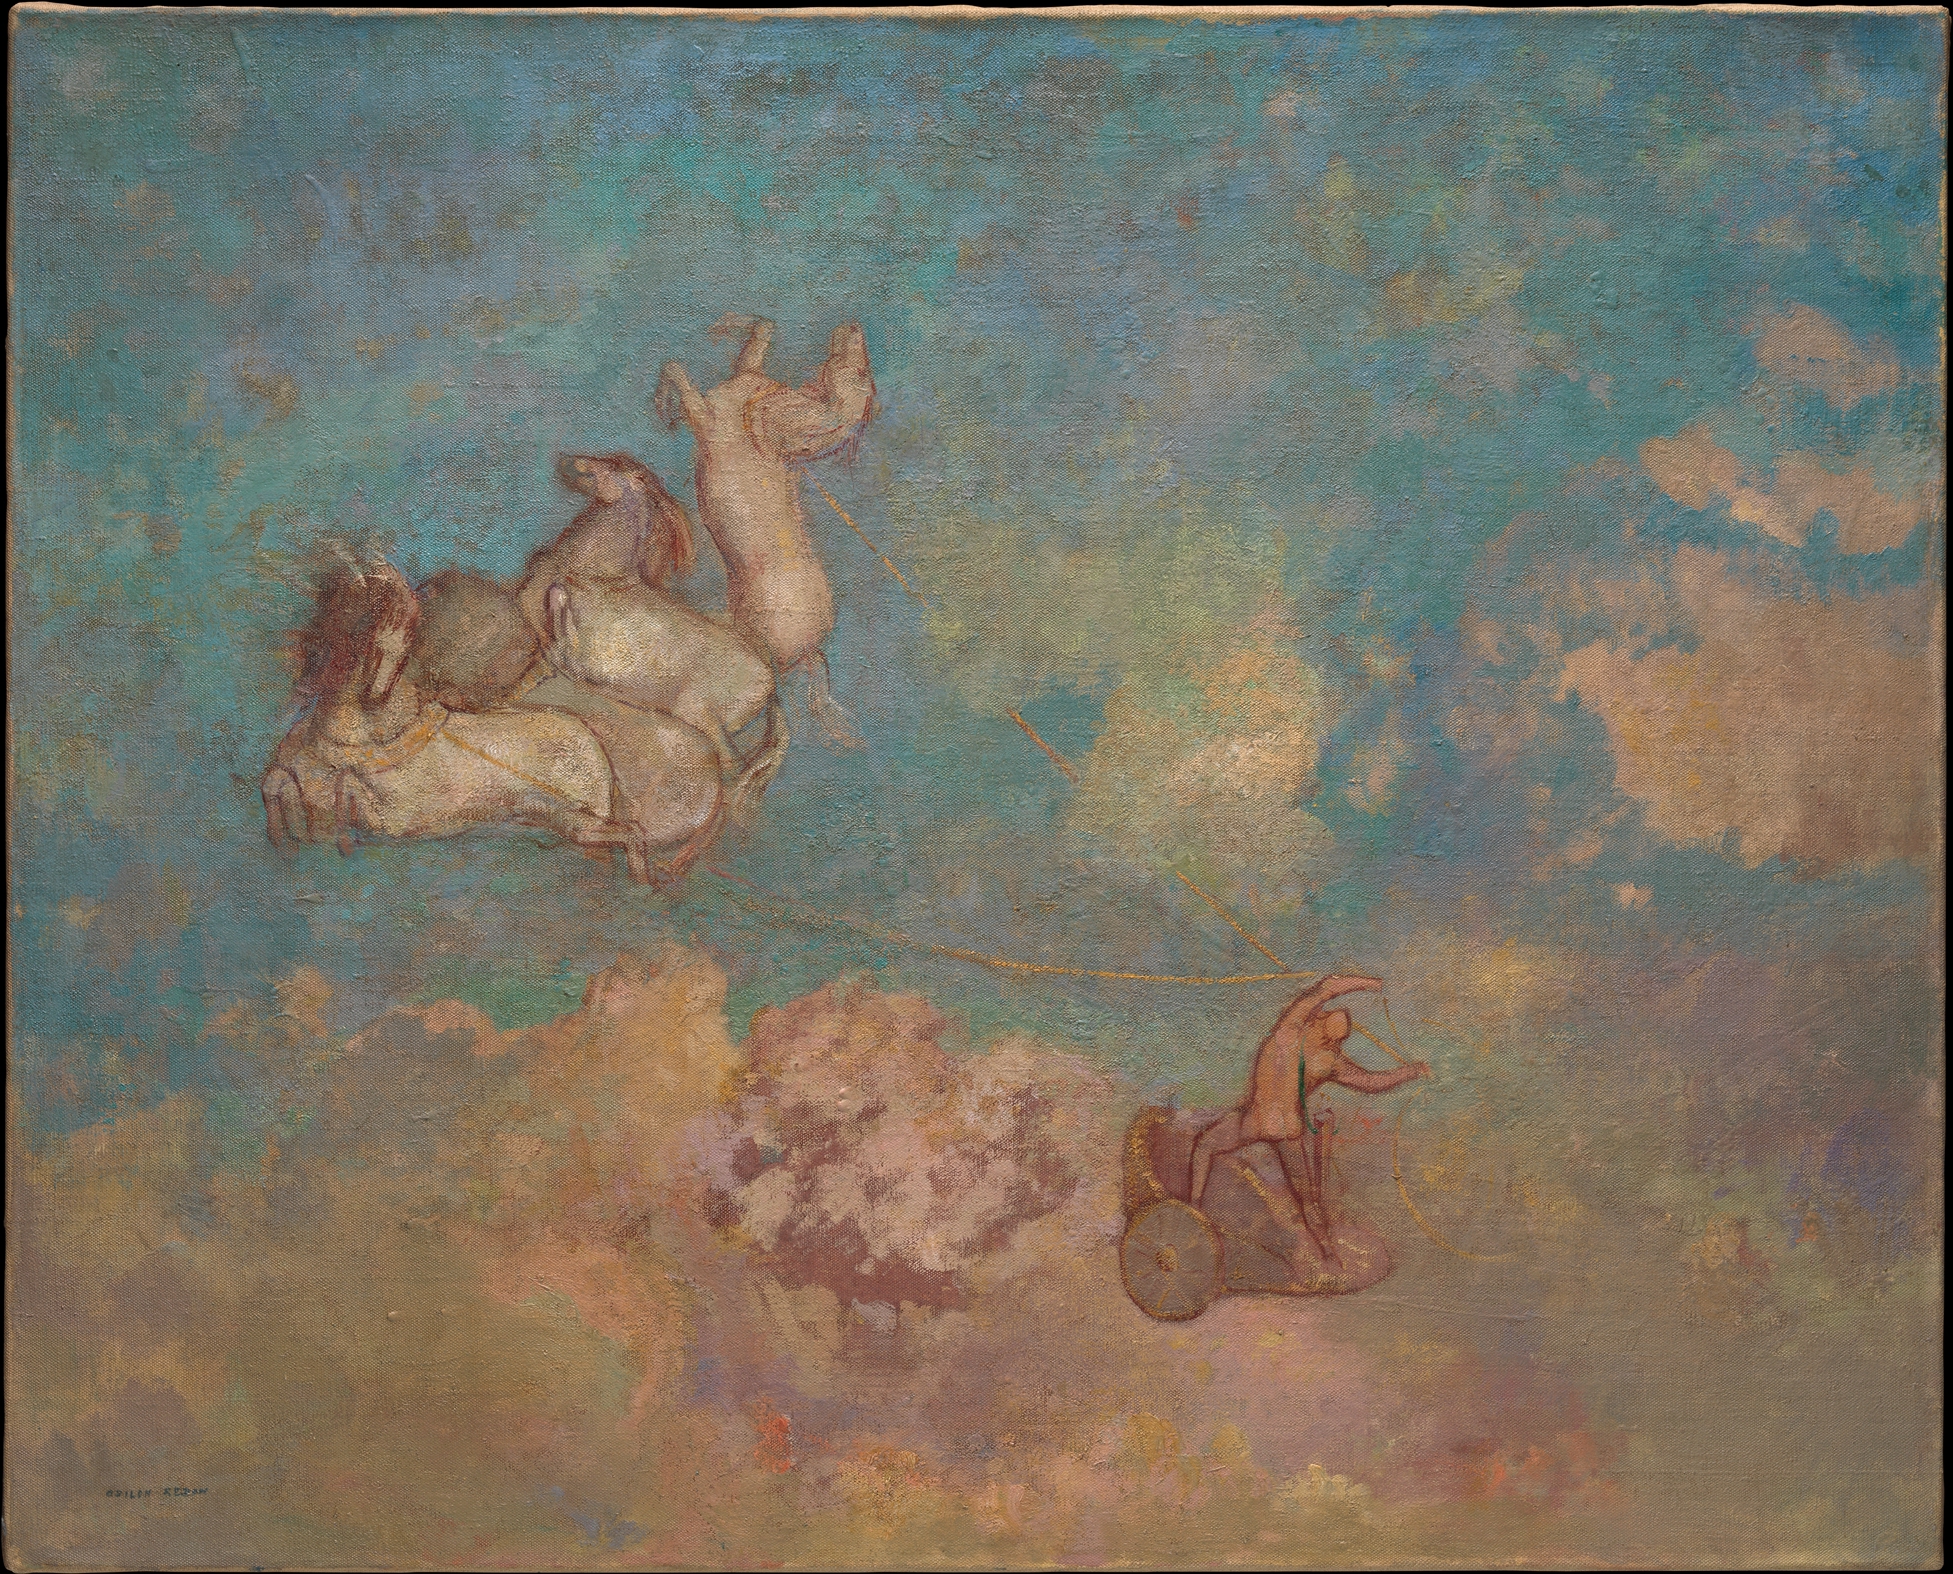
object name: painting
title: The Chariot of Apollo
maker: odilon redon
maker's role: artist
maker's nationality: french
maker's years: 1840-1916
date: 1905-1916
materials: canvas, oil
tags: apollo,horses,sky,chariots